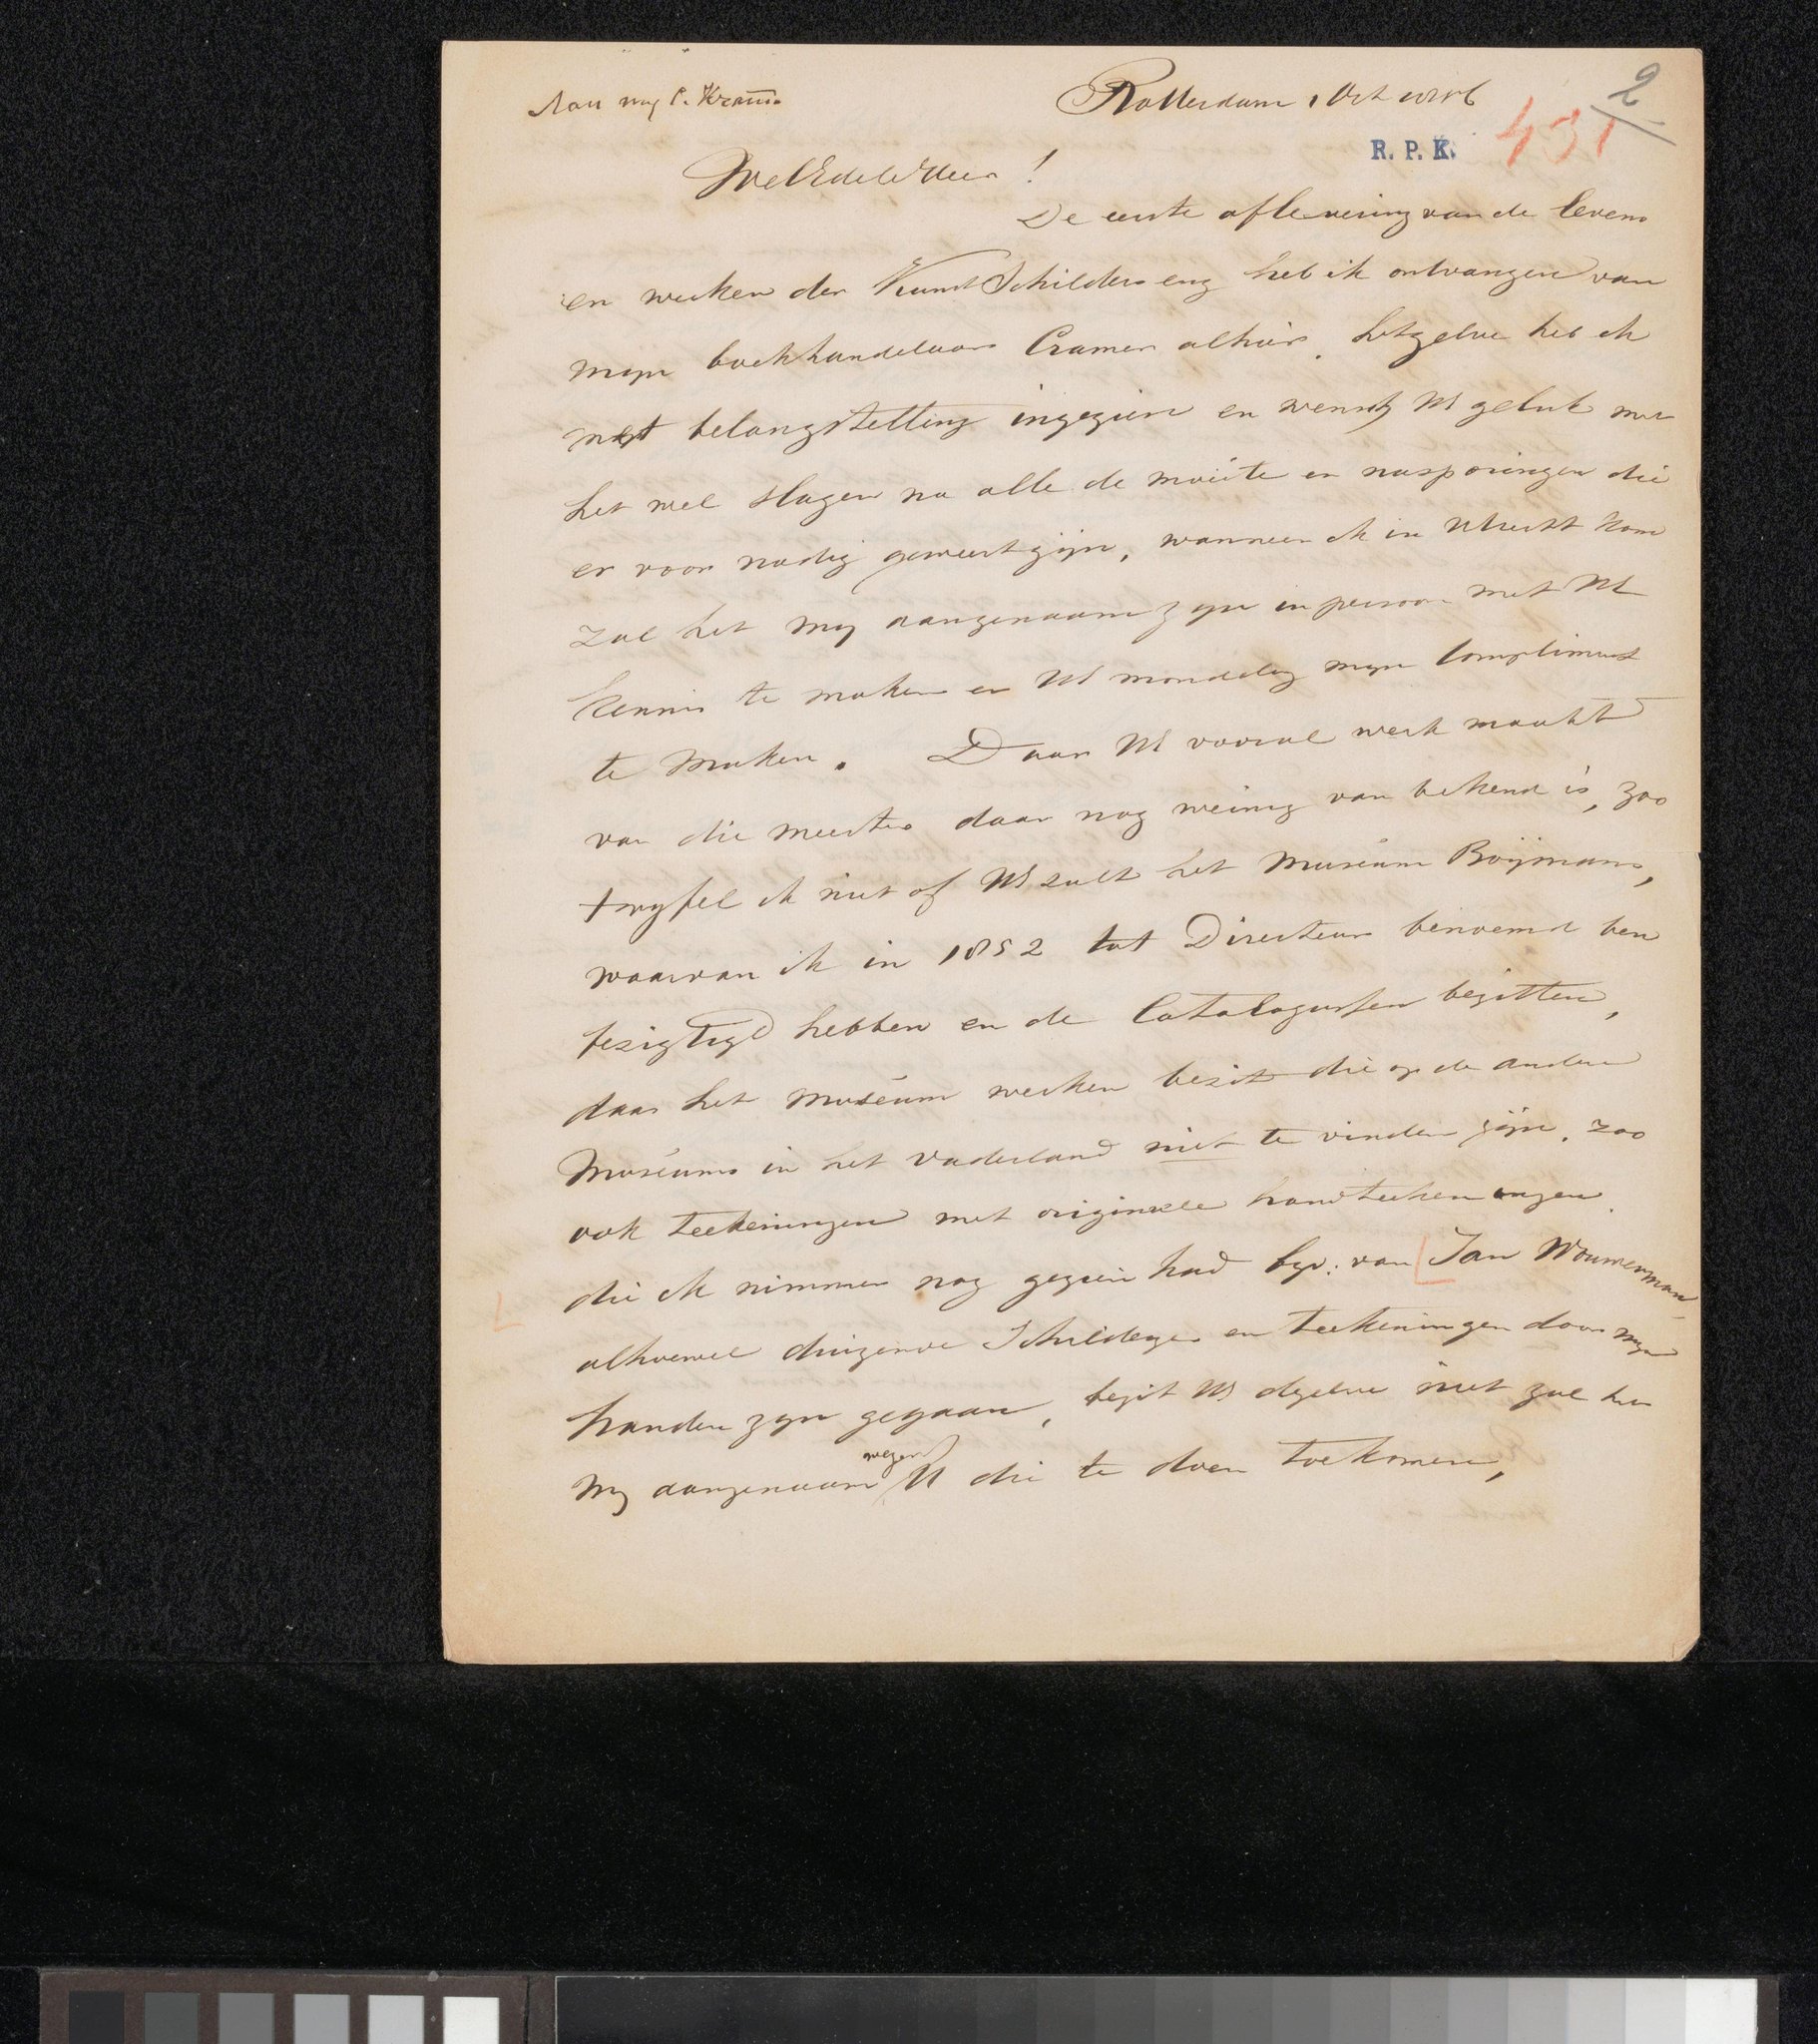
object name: letter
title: Brief aan Christiaan Kramm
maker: ary johannes lamme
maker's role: draughtsman, print maker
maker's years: 1812-1900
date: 1856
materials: ink, paper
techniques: pen, writing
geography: rotterdam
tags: wijnand nuijen, dordrecht, painter, sculptor, ary scheffer, dirk vis blokhuyzen, utrecht, print maker, draughtsman, christiaan kramm, rotterdam, drawing, the graphic arts, painting (including book-illumination, miniature-painting), art collecting, printed matter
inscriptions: collector's mark: Lugt 2233